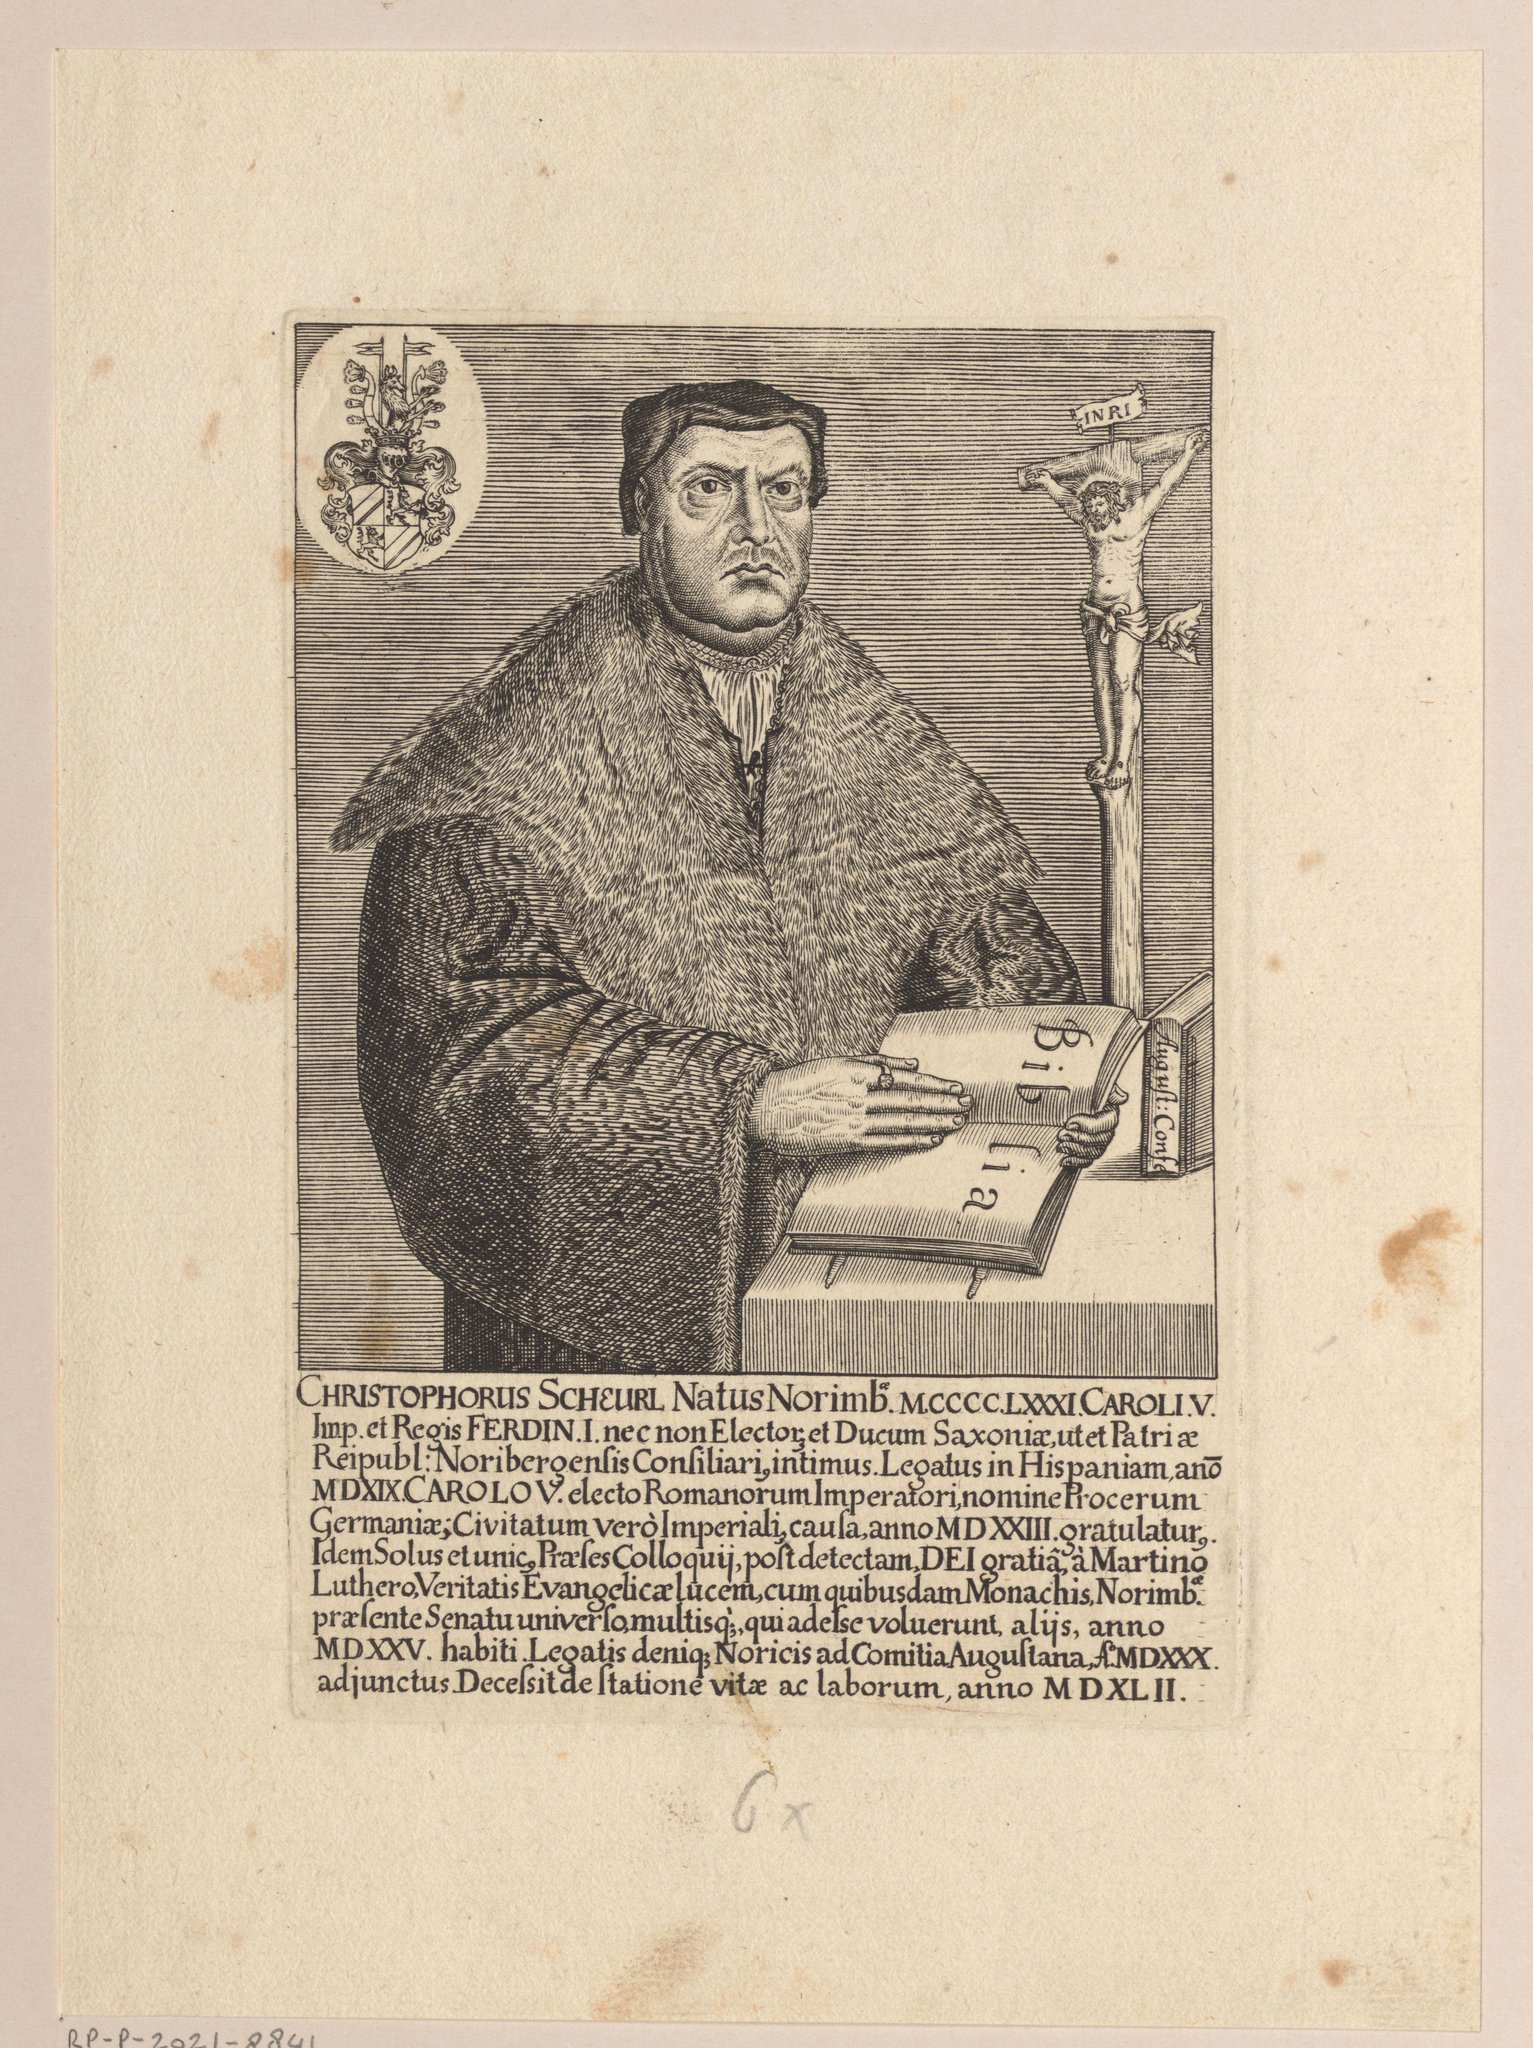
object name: print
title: Portret van Christoph von Scheurl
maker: Anonymous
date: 1600-1699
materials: paper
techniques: engraving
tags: historical persons, diplomacy, diplomat, crucifix ~ personal devotion, armorial bearing, heraldry